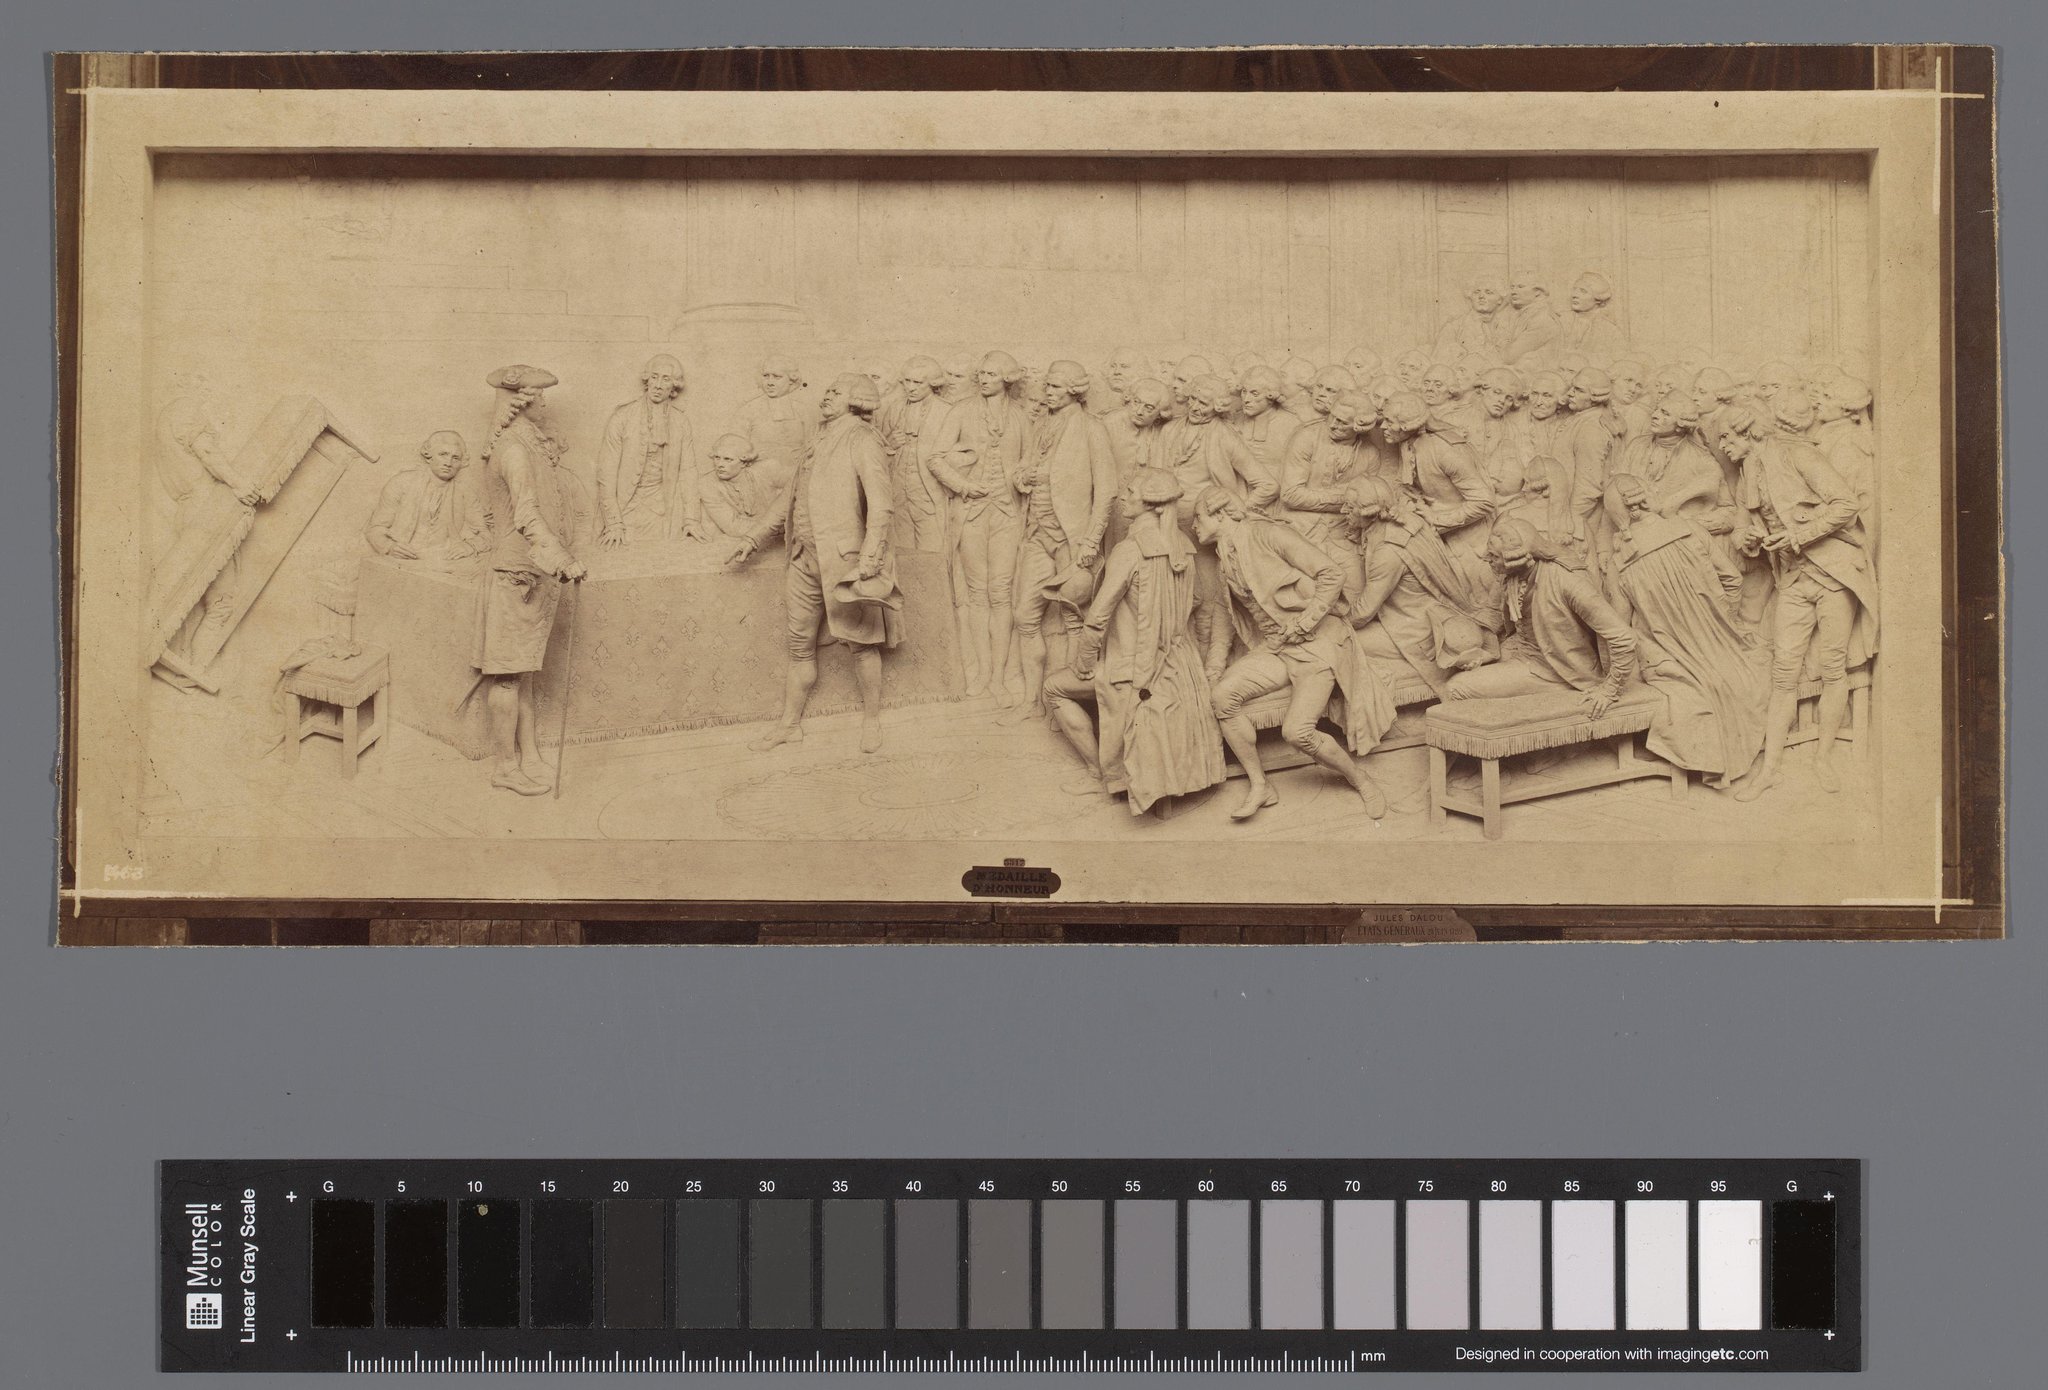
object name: photograph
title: Reliëf van het uitreiken van de Medal of Honor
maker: Anonymous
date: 1850-1900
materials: cardboard, photographic support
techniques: albumen print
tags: military honours, sculpture (+ relief ~ sculpture)